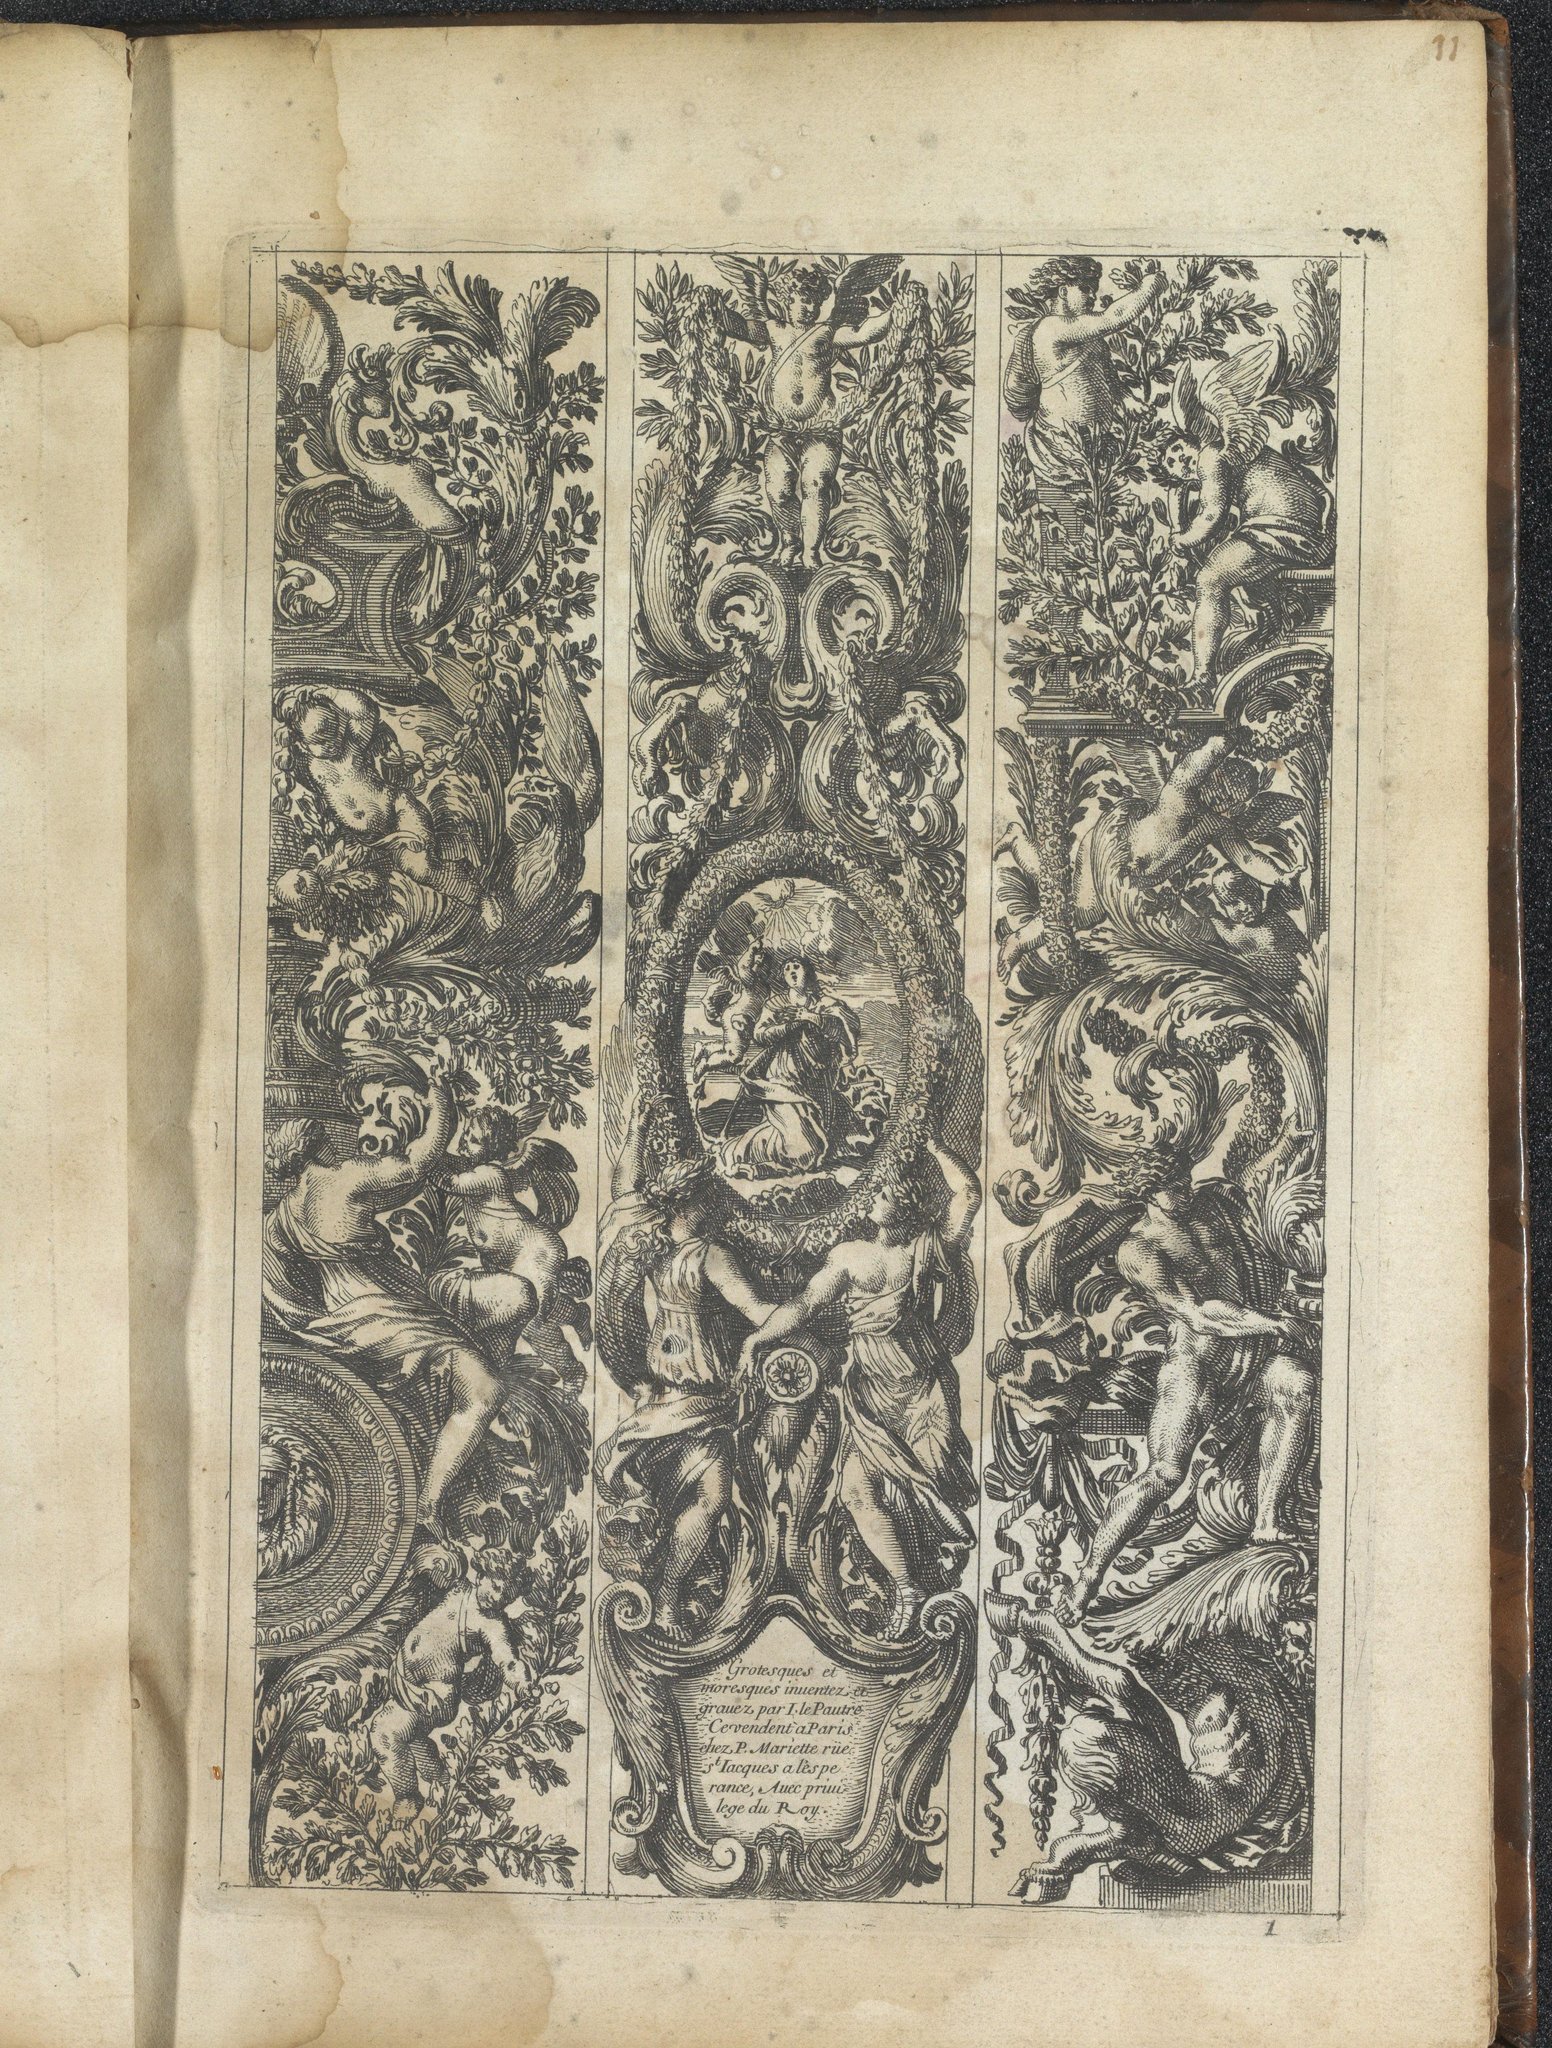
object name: ornament print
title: Drie verticale panelen met bladornament en figuren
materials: paper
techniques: etching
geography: paris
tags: ornament ~ grotesque, ornaments ~ art, hope, 'spes'; 'speranza divina e certa' (ripa) ~ one of the three theological virtues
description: Drie verticale panelen met bladornament en figuren. In het middelste paneel een ovaal medaillon met daarin de personificatie van Hoop. Prent maakt deel uit van een album.